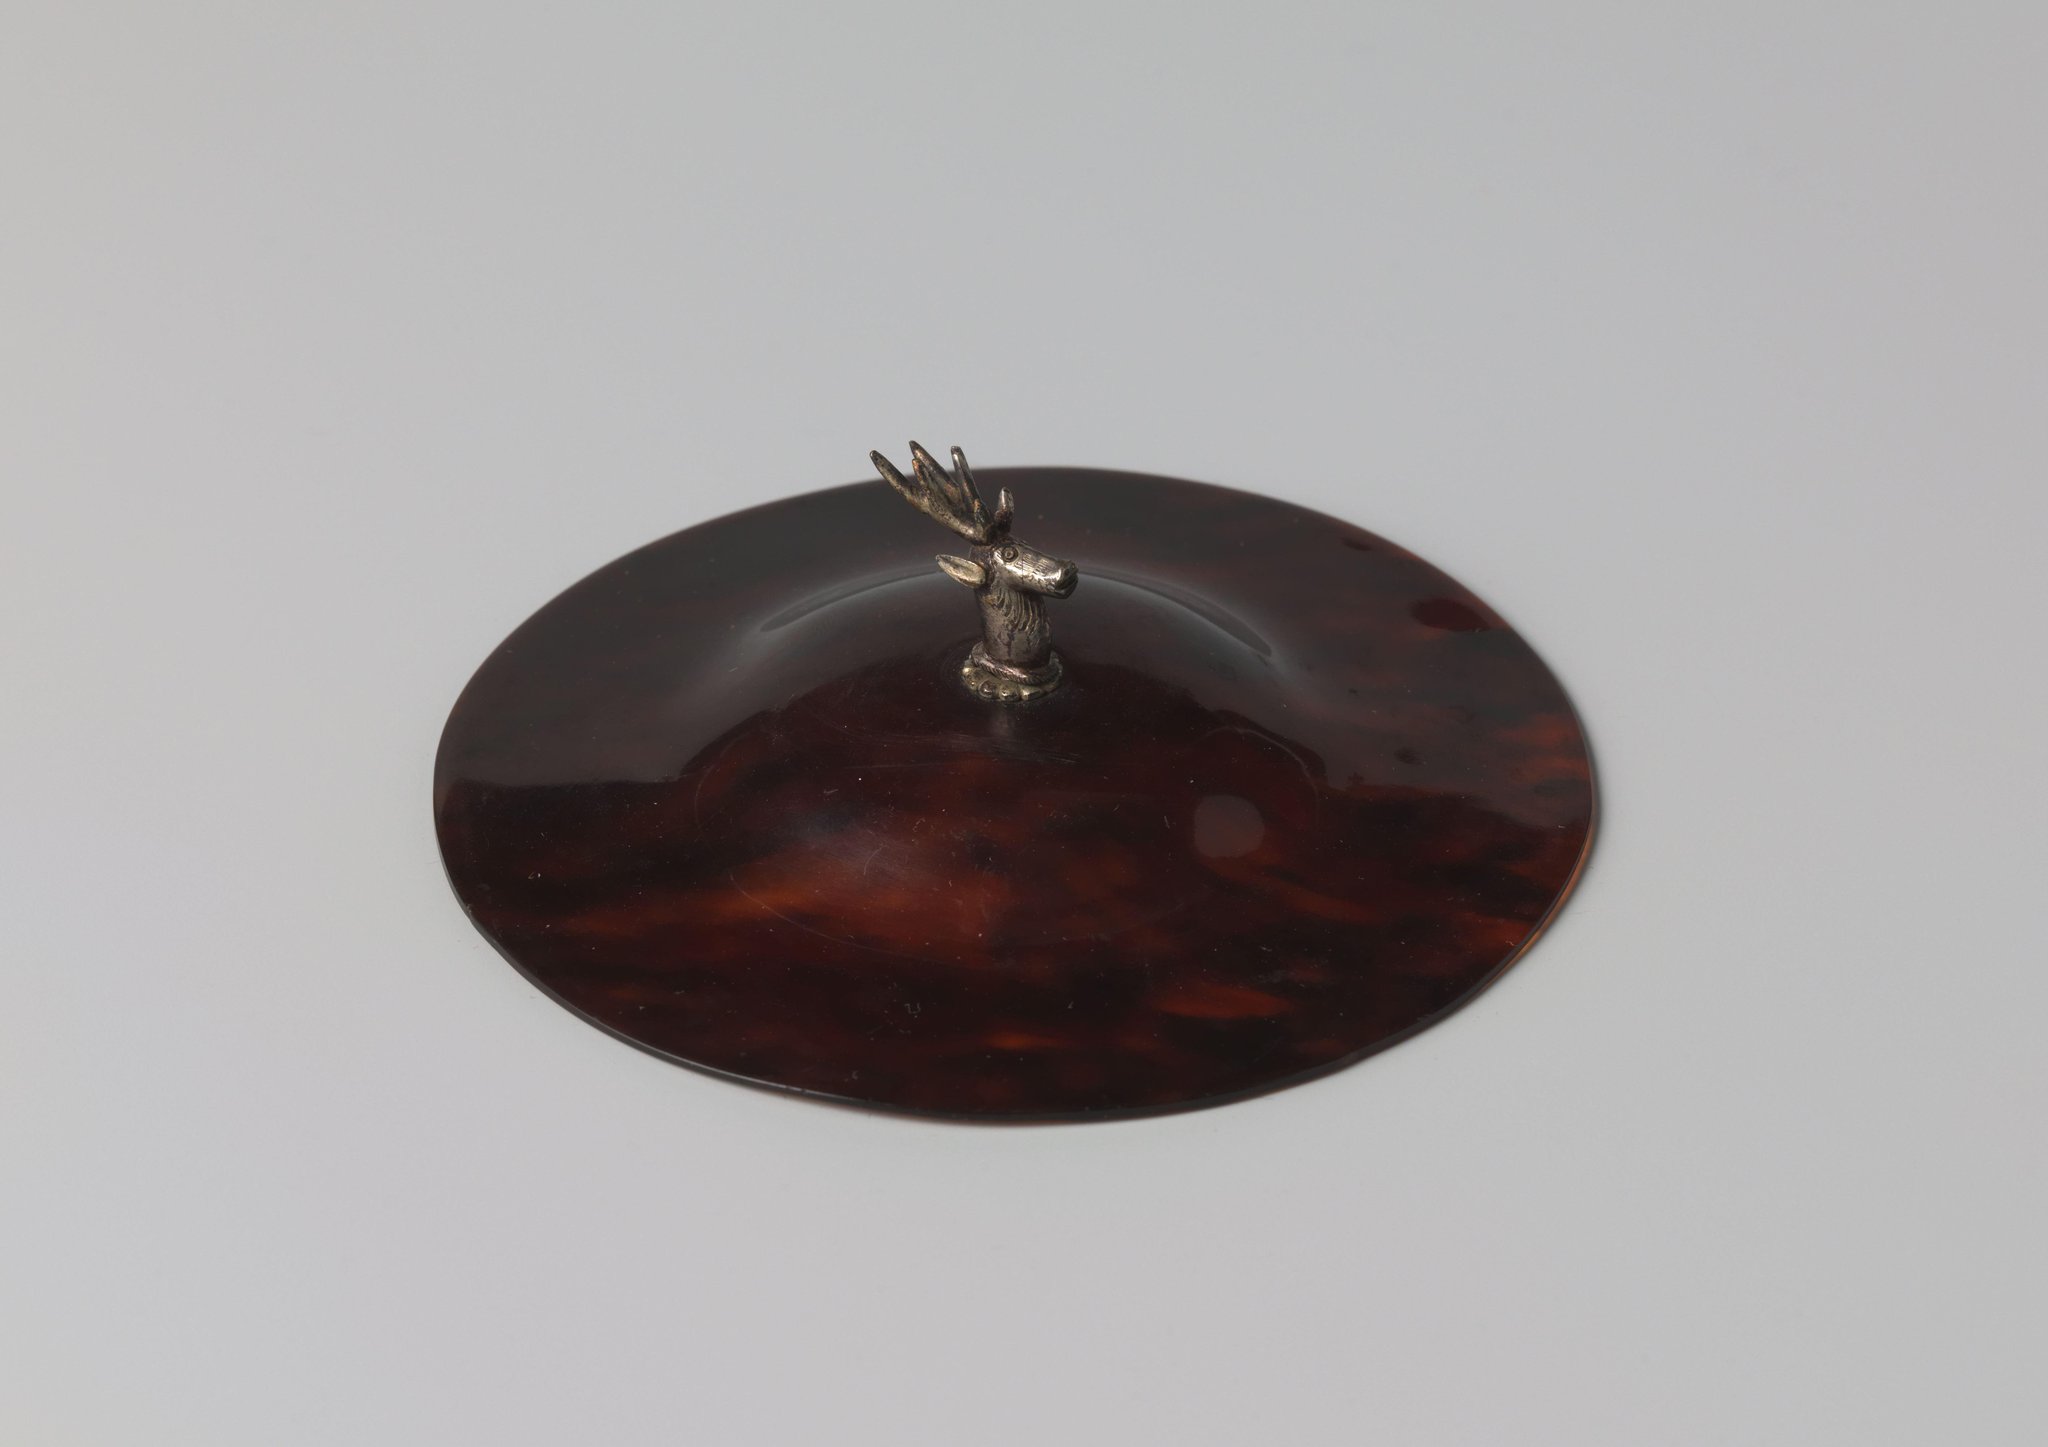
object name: schildpaddeksel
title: Deksel van schildpad met hertekop van zilver (serie van 28 stuks A t/m BB)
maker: Anonymous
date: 1700-1799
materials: silver, shell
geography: indonesia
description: Schildpad-deksel (28 stuks: A t/m BB) met hertekop van zilver als knop.